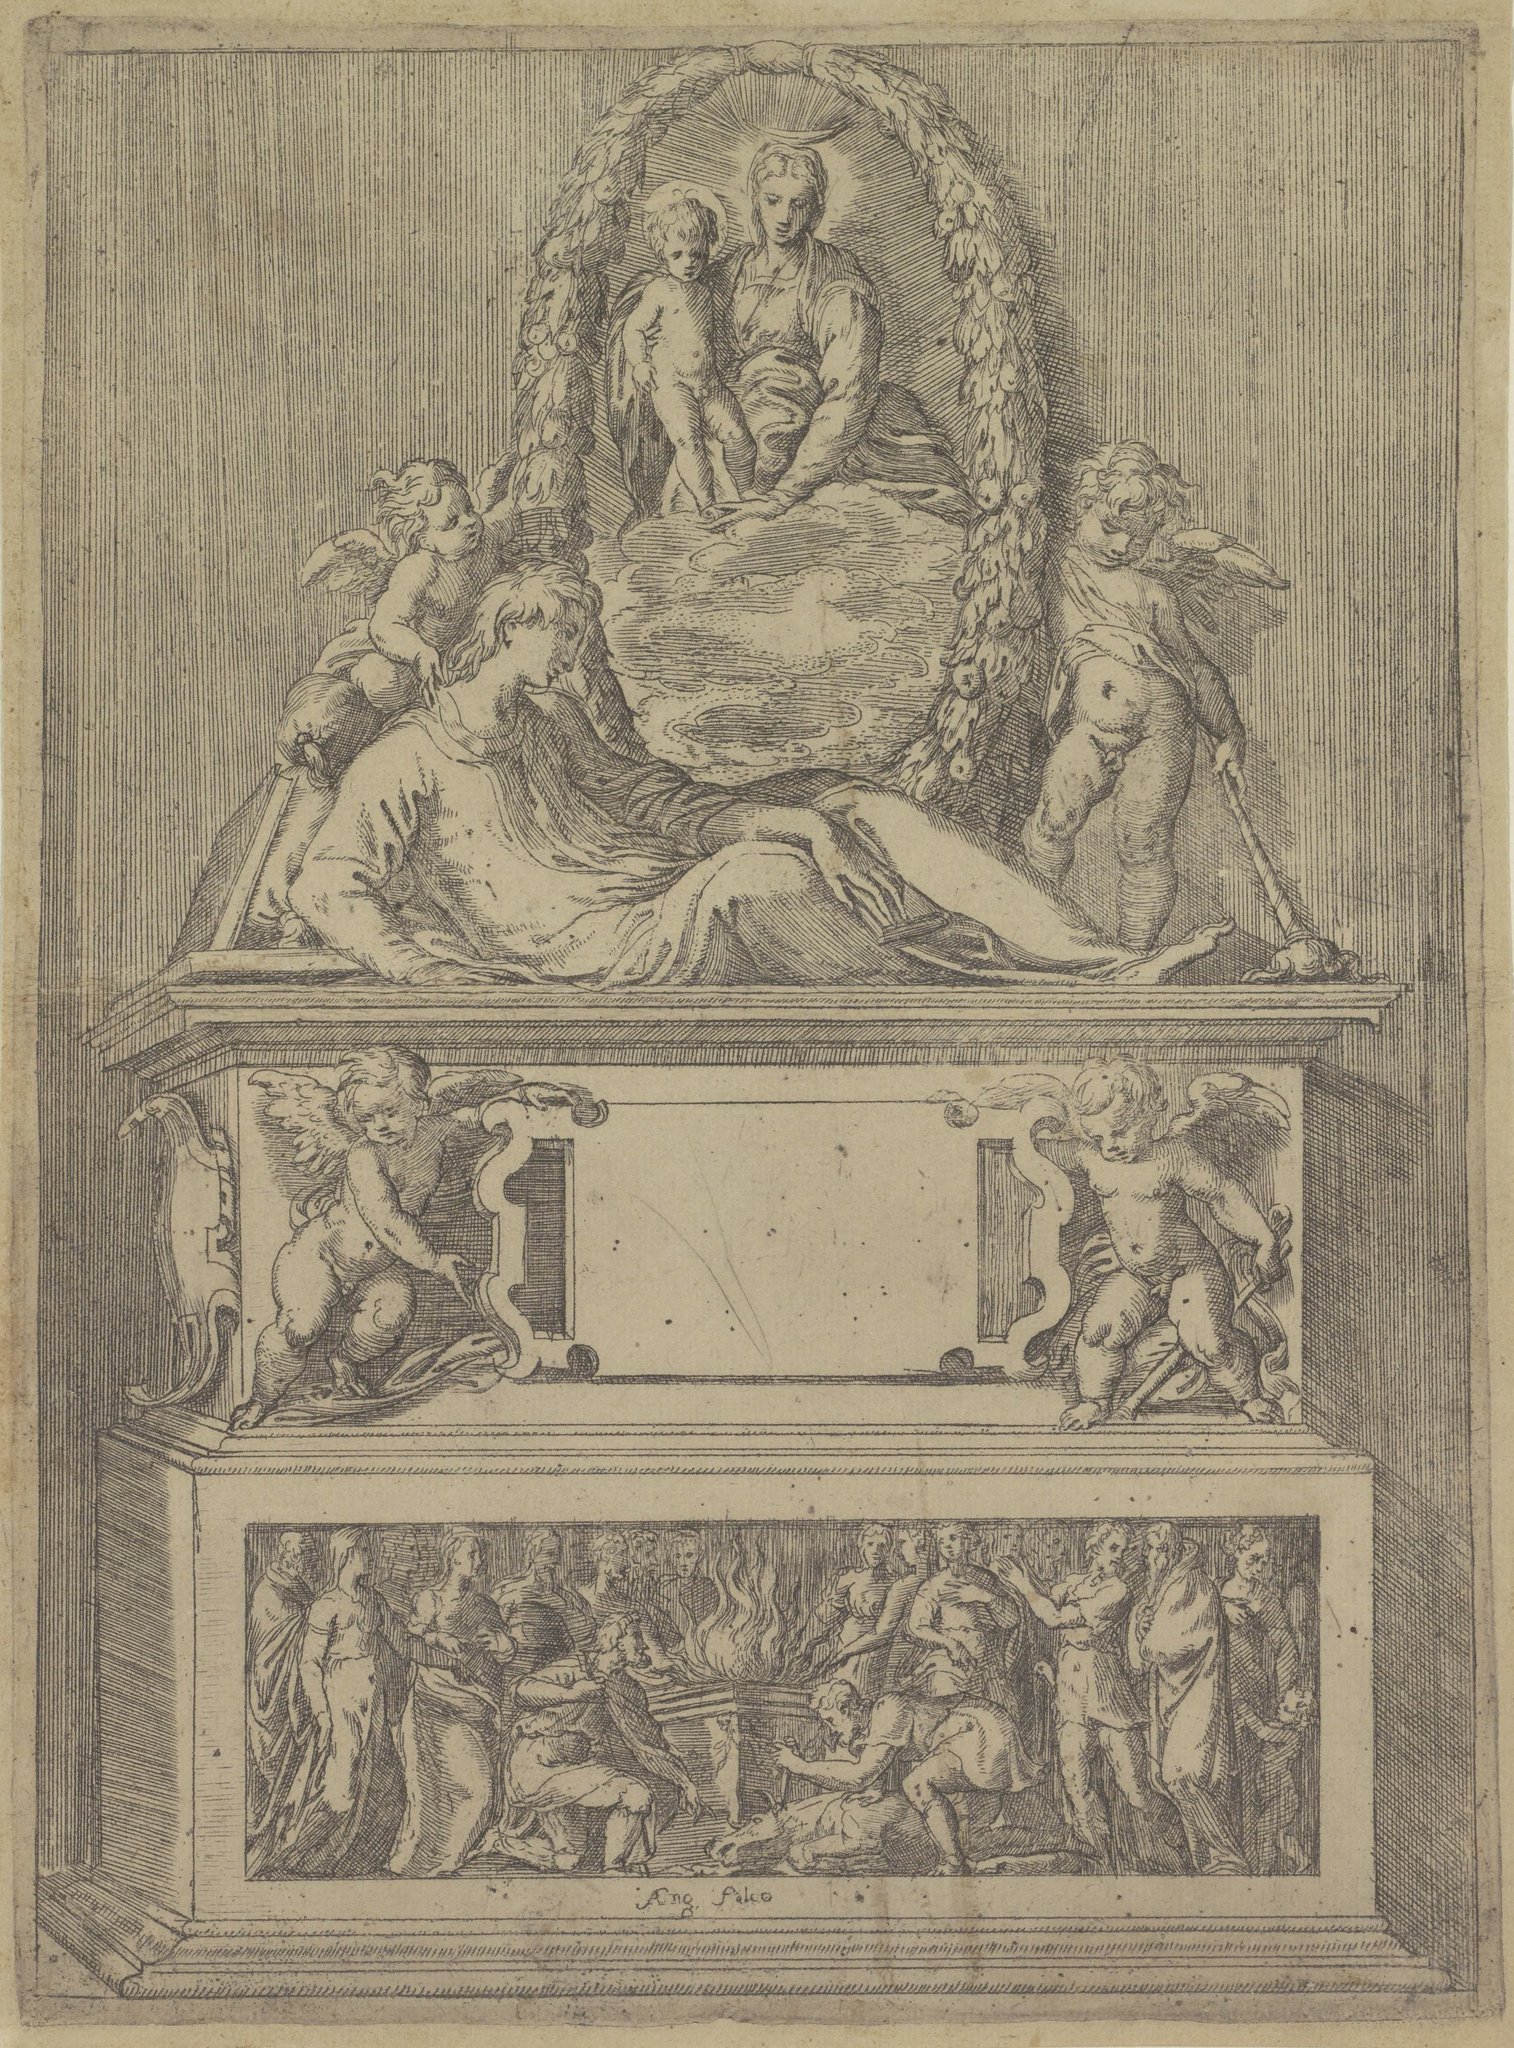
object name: print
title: Graftombe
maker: angelo falco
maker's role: print maker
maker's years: 1600-1695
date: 1619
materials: paper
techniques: etching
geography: italy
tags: madonna: i.e. mary with the christ-child, grave, tomb, cupids: 'amores', 'amoretti', 'putti'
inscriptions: collector's mark: Lugt 240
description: Een graftombe bestaande uit drie lagen. Onder een voorstelling van een offerritueel. Daarboven twee putti naast een leeg cartouche. Bovenop een liggende figuur en een voorstelling van Maria met Kind die aan weerszijden wordt geflankeerd door een putto.